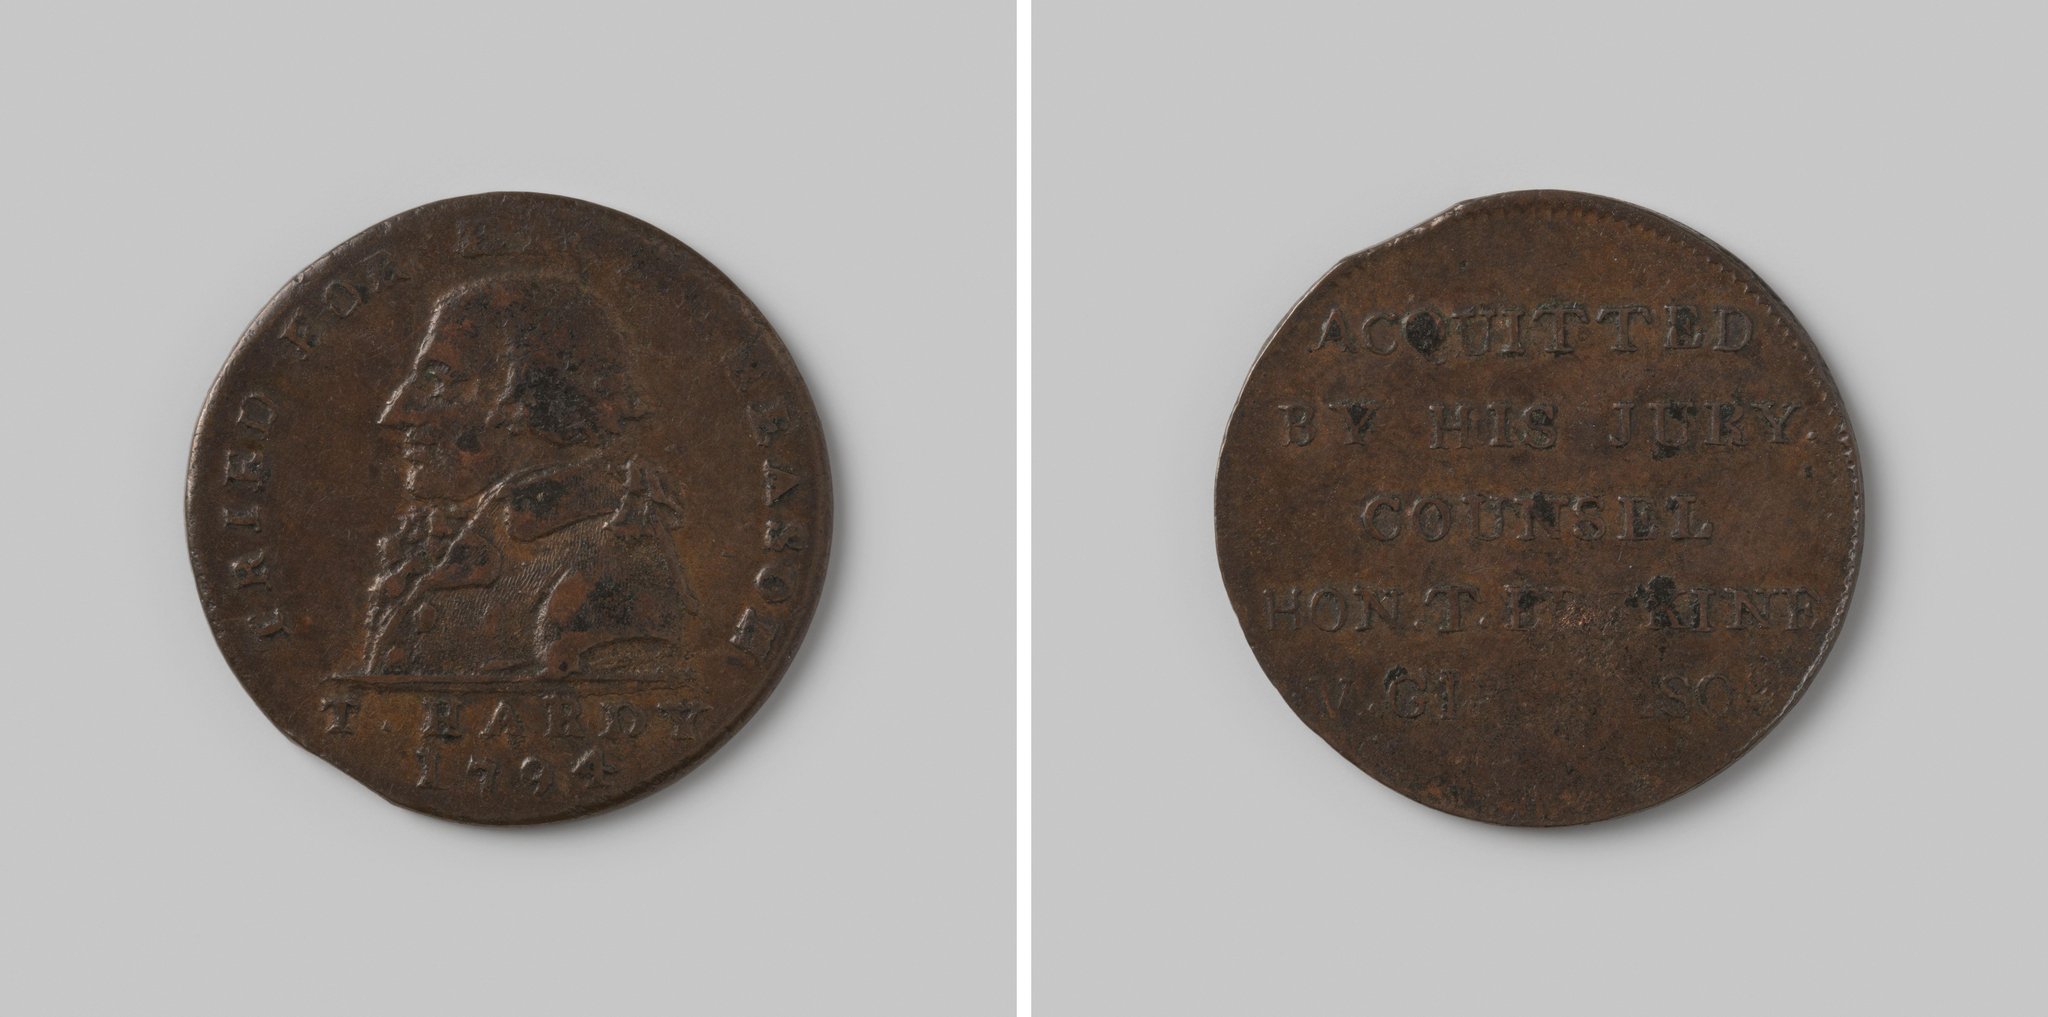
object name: history medal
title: Berechting van Thomas Hardy 1794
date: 1794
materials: copper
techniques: striking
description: Koperen penning, op de voorzijde het borstbeeld van Hardy naar links met omschrift en afsnedetekst, op de keerzijde vijf regels tekst.